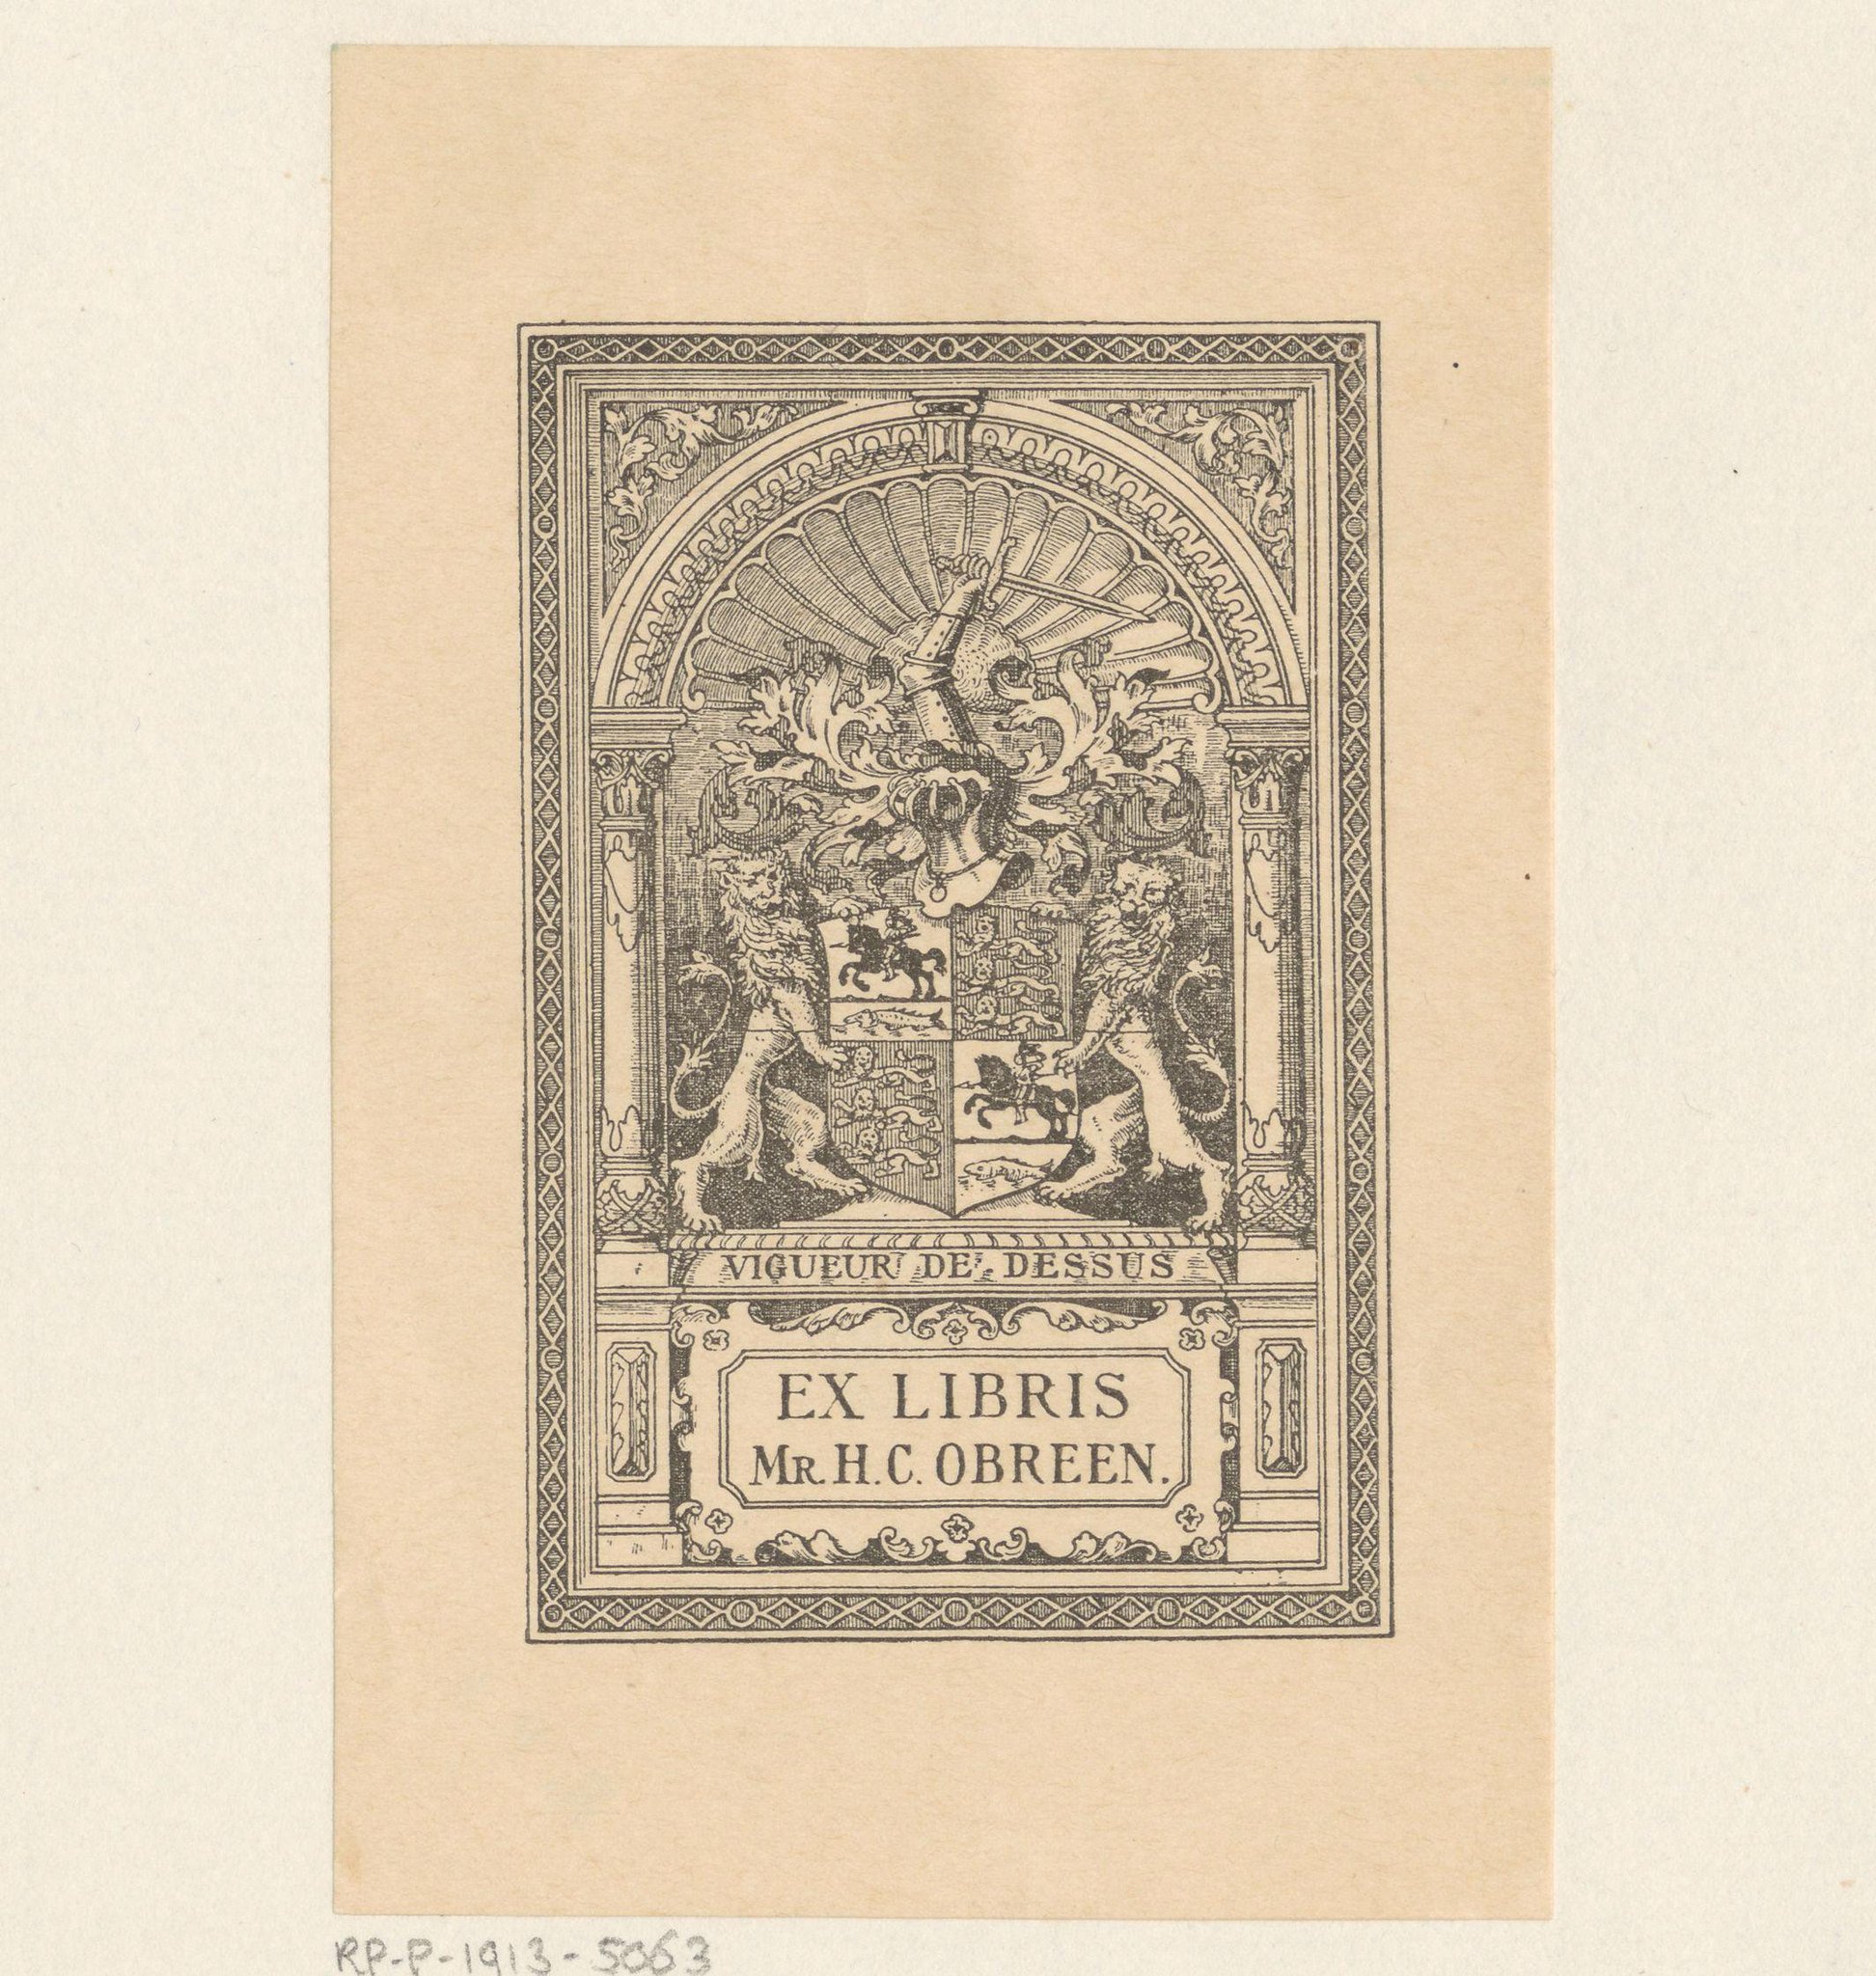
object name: bookplate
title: Ex libris van H.C. Obreen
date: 1874-1913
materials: paper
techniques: printing block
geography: netherlands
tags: leiden, column, pillar ~ architecture, arch, archivolt ~ architecture, armorial bearing, heraldry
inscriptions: collector's mark: Lugt 2760, collector's mark: Lugt 2233